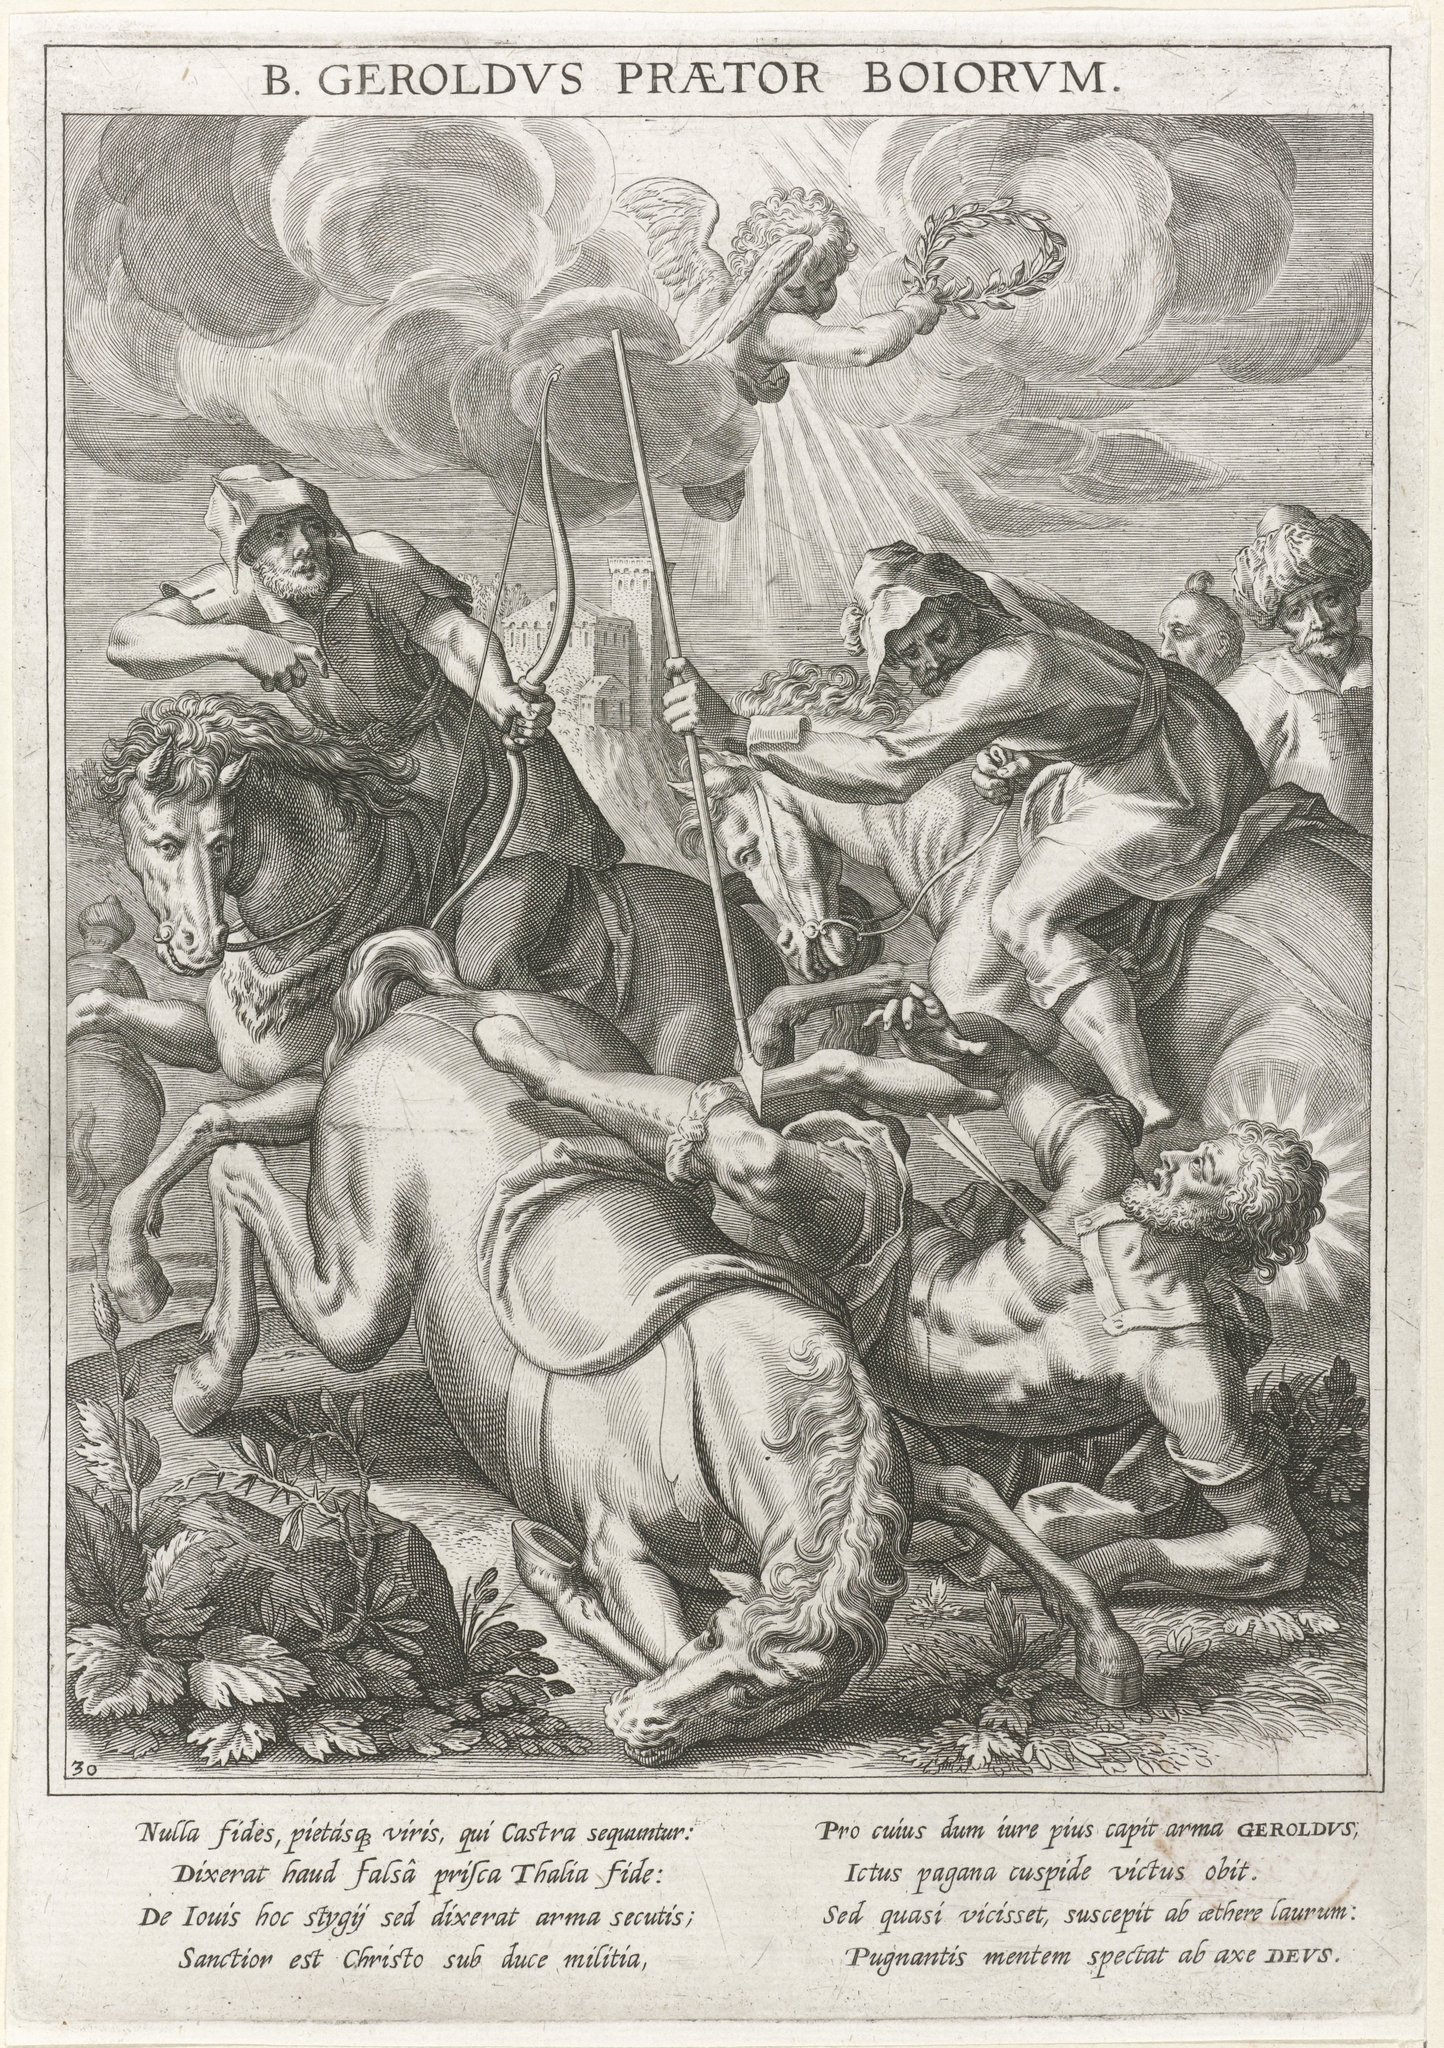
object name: print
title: Heiligen van Beieren I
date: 1615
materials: paper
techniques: engraving, etching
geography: munich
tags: angels crowning and/or bringing palm-branches, violent death by arrow(s)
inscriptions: collector's mark: Lugt 240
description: Gerold, gouverneur van Beieren, wordt aangevallen door de Avaren. Hij wordt van zijn paard gesleurd en met een pijl doorboord. Een engeltje daalt uit de hemel af om haar ziel op te nemen. De prent heeft een Latijns onderschrift en is de 30ste prent van een 60-delige serie met als onderwerp de heiligen van Beieren.